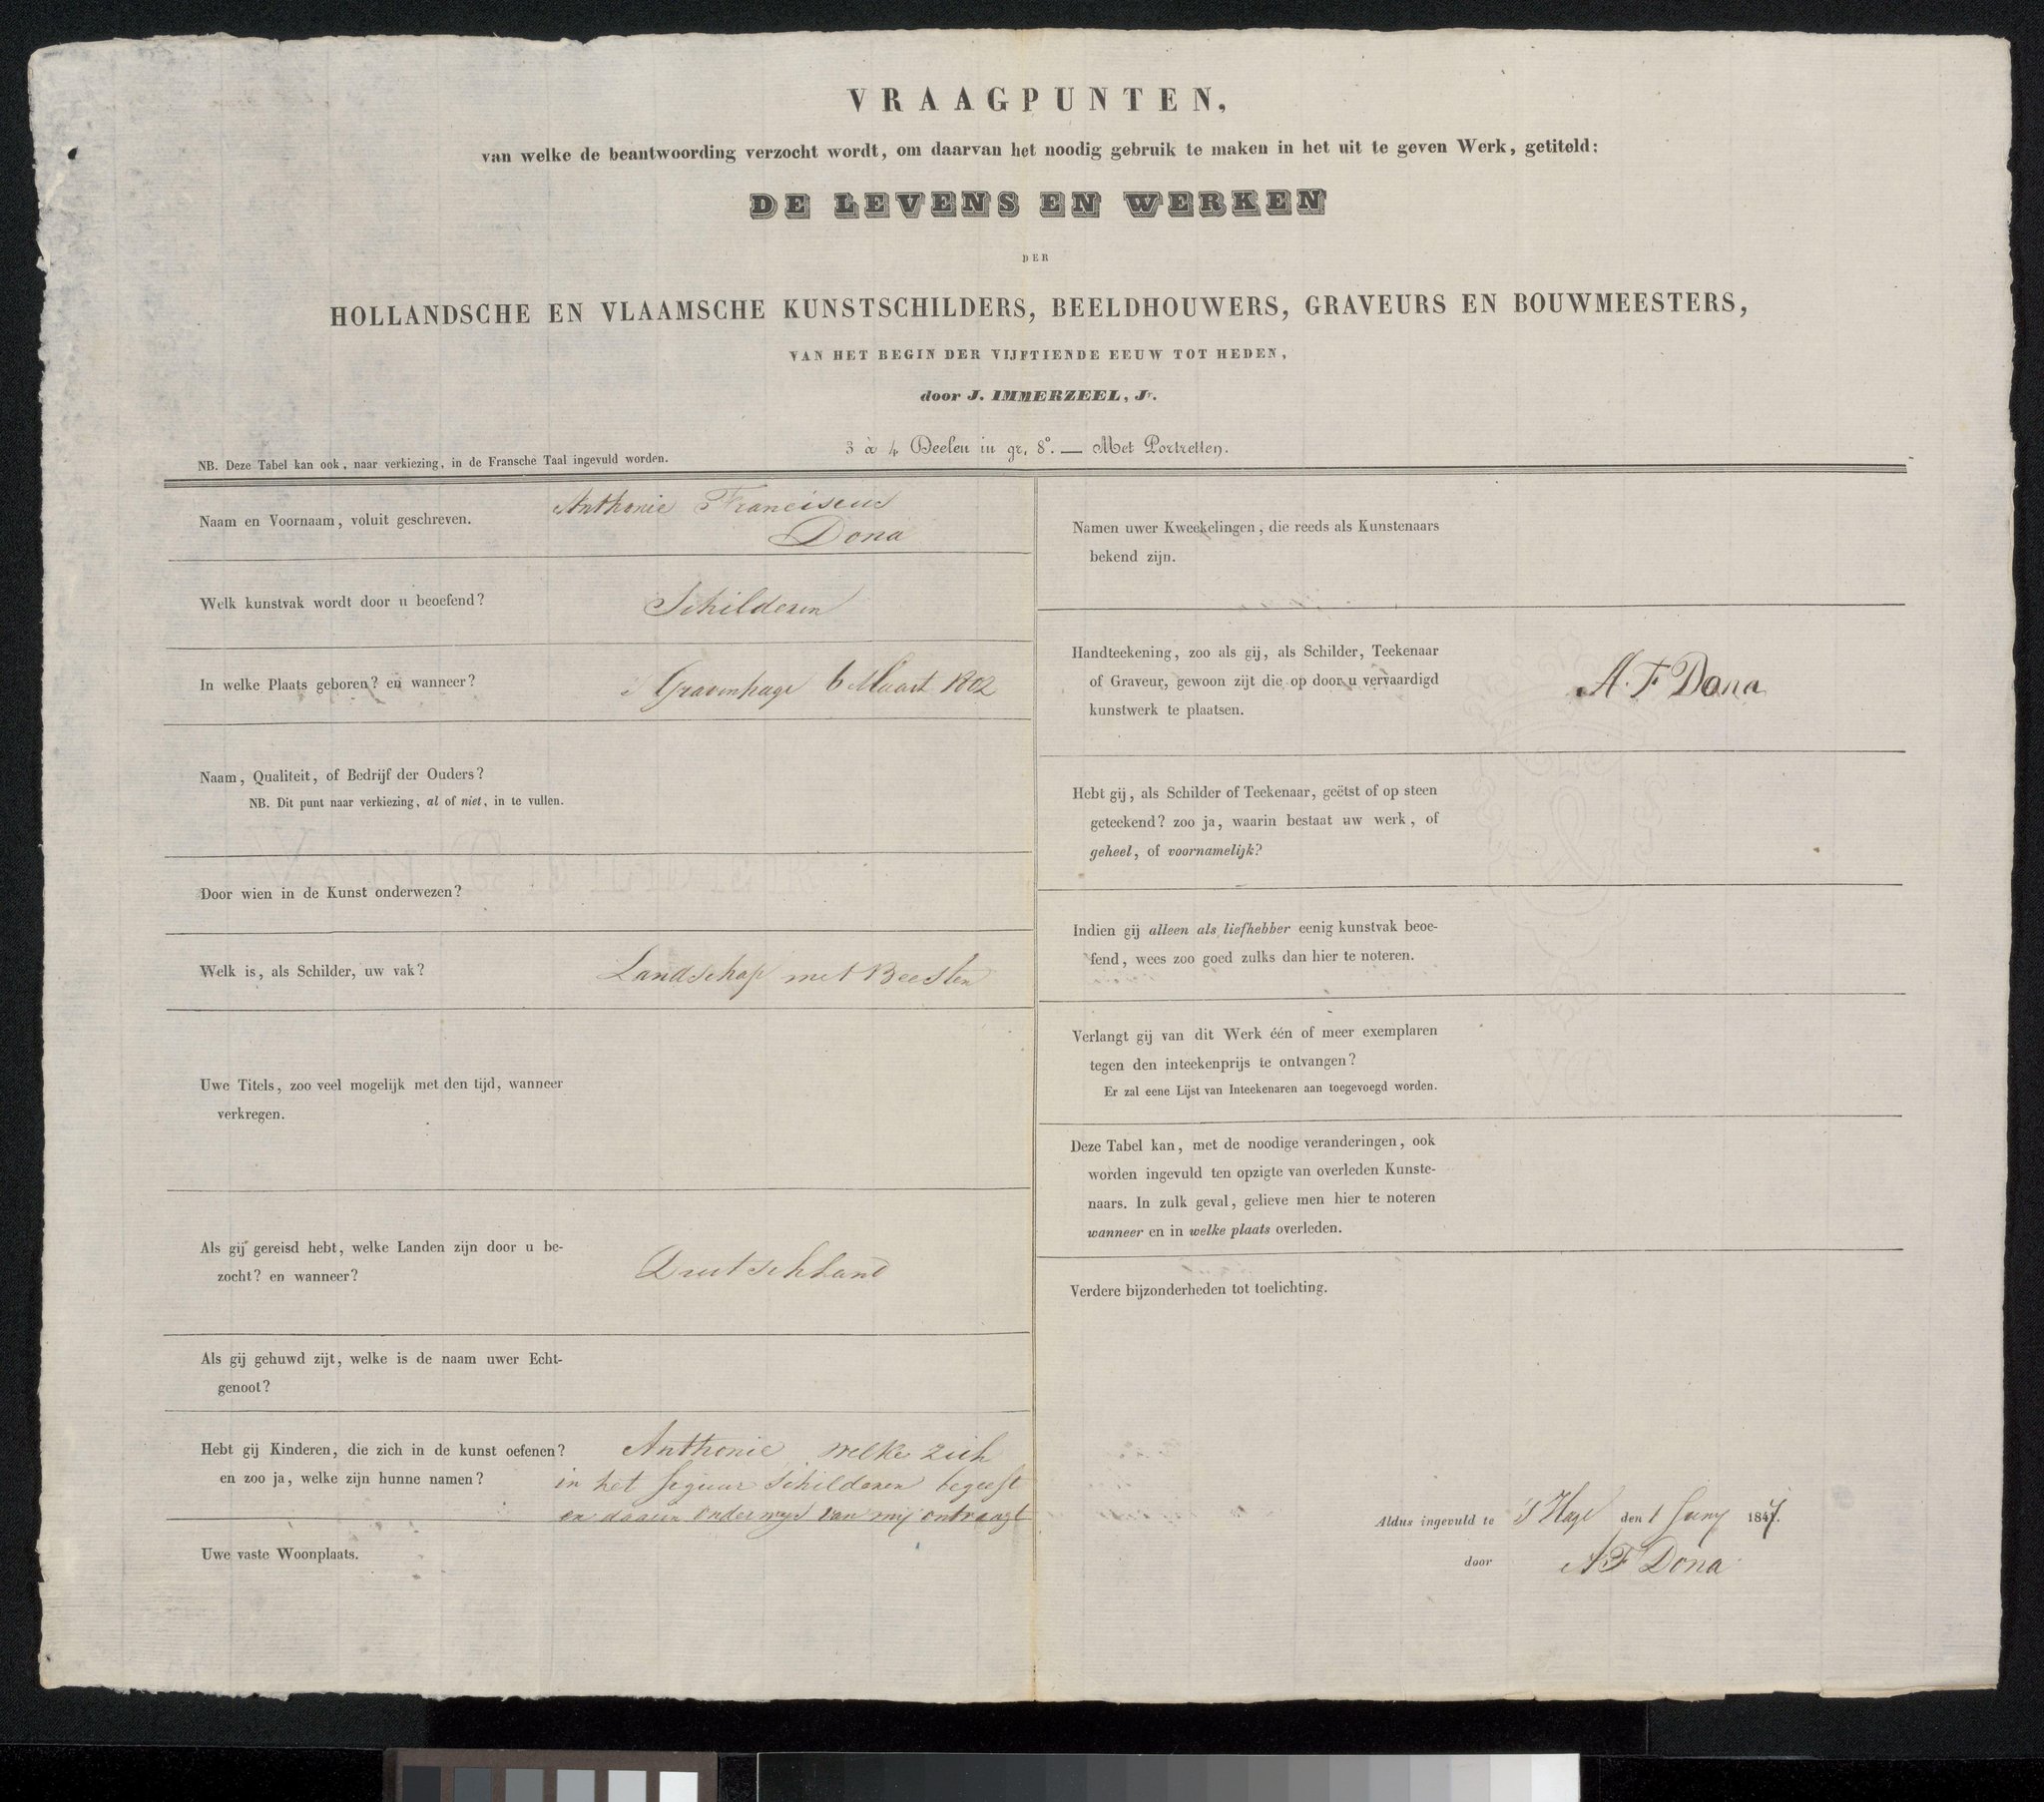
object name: questionnaire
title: Enquêteformulier ingevuld door Antonie Franciscus Dona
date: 1847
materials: ink, paper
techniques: pen, printing, writing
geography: the hague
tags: the hague, print maker, draughtsman, antonie franciscus dona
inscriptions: inscription: ‘Vraagpunten,/ van welke de beantwoording verzocht wordt, om daarvan het noodig gebruik te maken in het uit te geven Werk, getiteld: De levens en werken/ der Hollandsche en Vlaamsche kunstschilders, beeldhouwers,/ graveurs en bouwmeesters, van het begin der vijftiende eeuw tot heden/ door J. Immerzeel, Jr.’, watermark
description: Bedoeld voor: Immerzeel, J. Jr., De levens en werken der Hollandsche en Vlaamsche kunstschilders, beeldhouwers, graveurs en bouwmeesters, van het begin der vijftiende eeuw tot heden, Amsterdam: J.C. van Kesteren, 1842-1843.